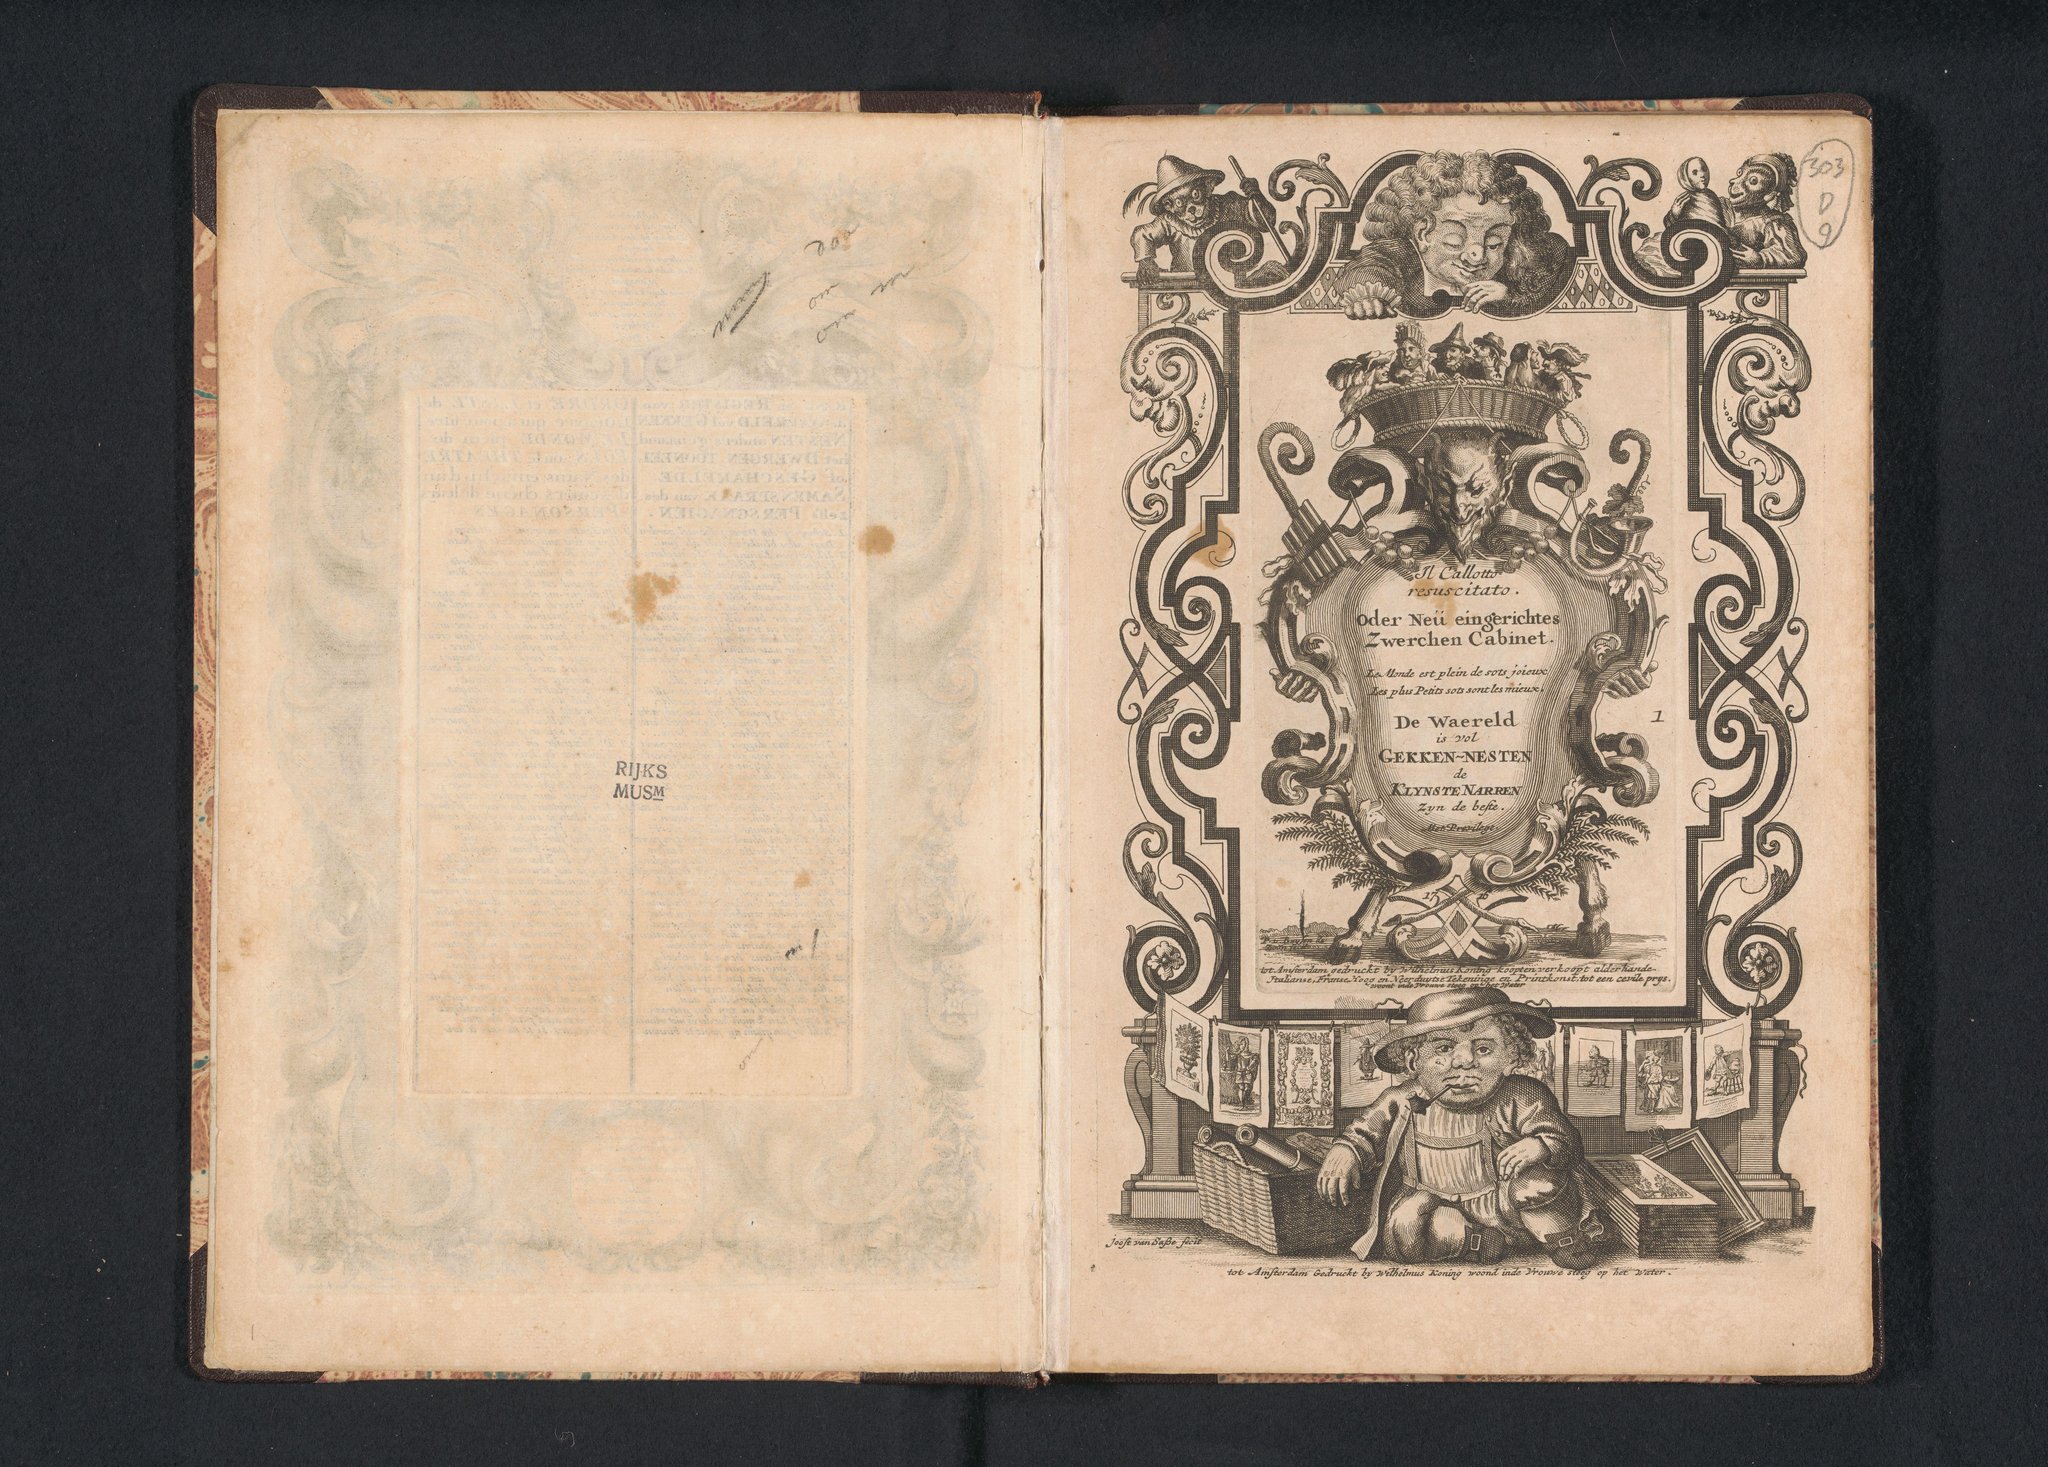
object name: print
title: Titelprent voor de serie: Il Callotto resuscitato oder Neü eingerichtes Zwerchen Cabinet, 1716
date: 1716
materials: paper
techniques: etching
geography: northern netherlands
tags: caricatures (human types), little people, print, e.g.: engraving, etching, lithograph, street-trader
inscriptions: collector's mark: Lugt 2166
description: Titelprent voor de serie getiteld: Il Callotto resuscitato oder Neü eingerichtes Zwerchen Cabinet. Embleem samengesteld uit een cartouche en een duivel met op zijn hoofd een mand met kleine mensen. Afdruk binnen een decoratieve omlijsting gedrukt van een aparte plaat met apen en een kleine mens als prentenverkoper. Genummerd rechts: 1. Onderdeel van de Nederlandse gebonden uitgave uit 1716 van een serie karikaturen van kleine mensen, bekend als Het Dwergentooneel, gekopieerd naar een ouder Duits voorbeeld.